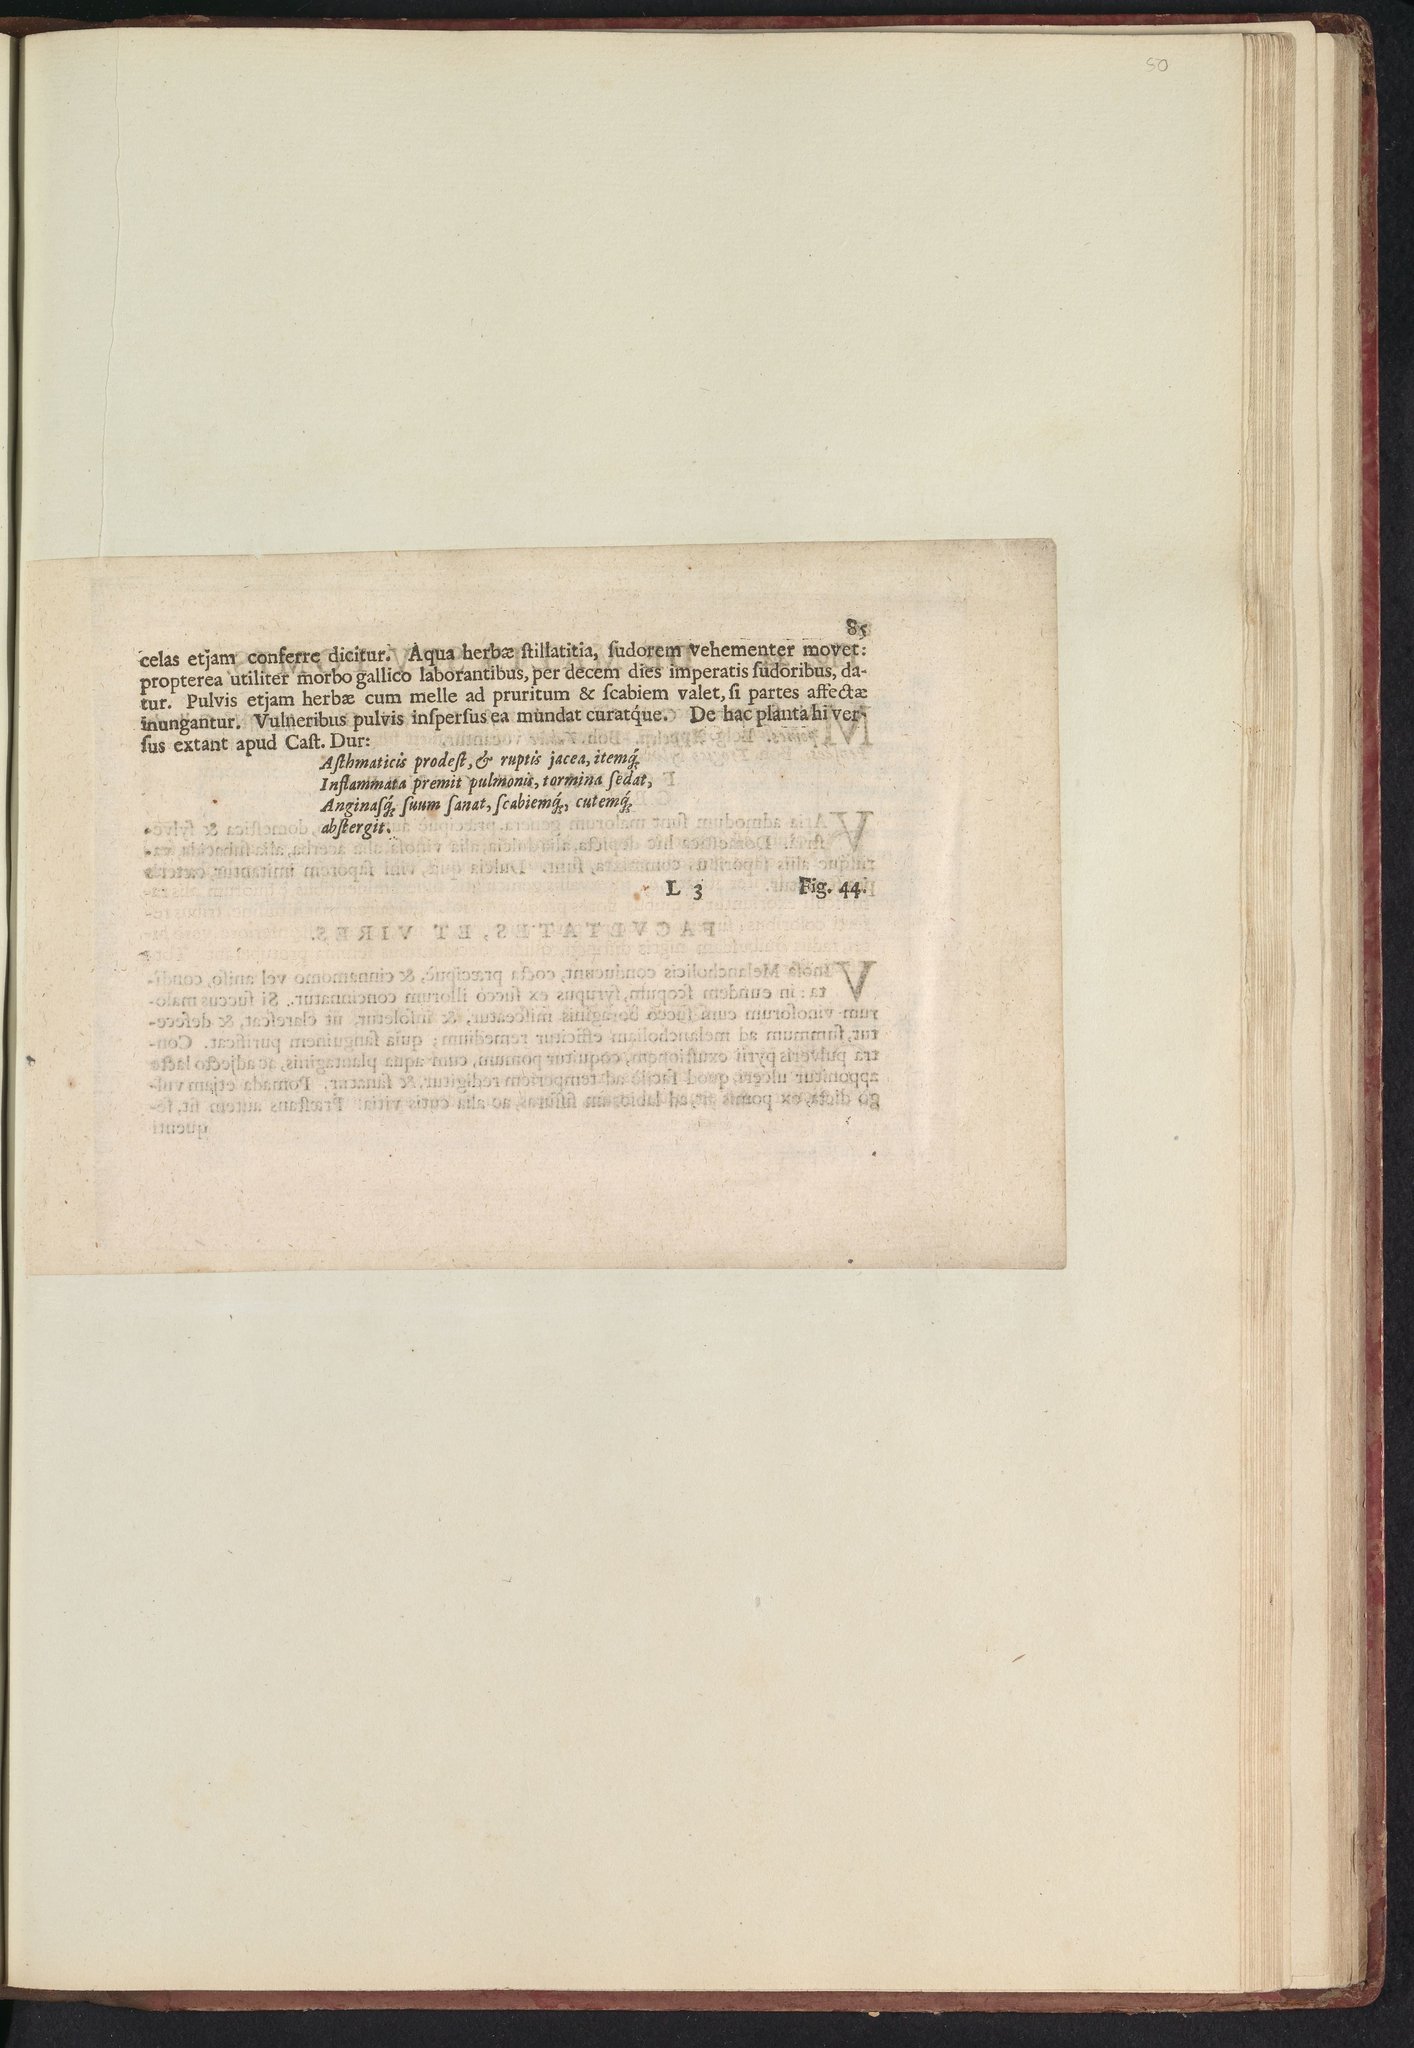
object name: text sheet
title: Fig. 43 'De Viola Flammea' in De Boodts herbarium van 1640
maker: anselmus boëtius de boodt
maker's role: draughtsman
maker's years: 1550-1632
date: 1640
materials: ink, paper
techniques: letterpress printing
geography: bruges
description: Beschrijving bij Fig. 43 op p. 85 in: Anselmi Boëtii de Boot I.C. Brugensis & Rodolphi II. Imp. Roman. medici a cubiculis Florum, Herbarum, ac fructuum selectiorum icones, & vires pleraeque hactenus ignotæ. Onderdeel van het album met bladen en platen uit De Boodts herbarium van 1640. Het twaalfde van twaalf albums met aquarellen van dieren, vogels en planten bekend rond 1600, gemaakt in opdracht van keizer Rudolf II.